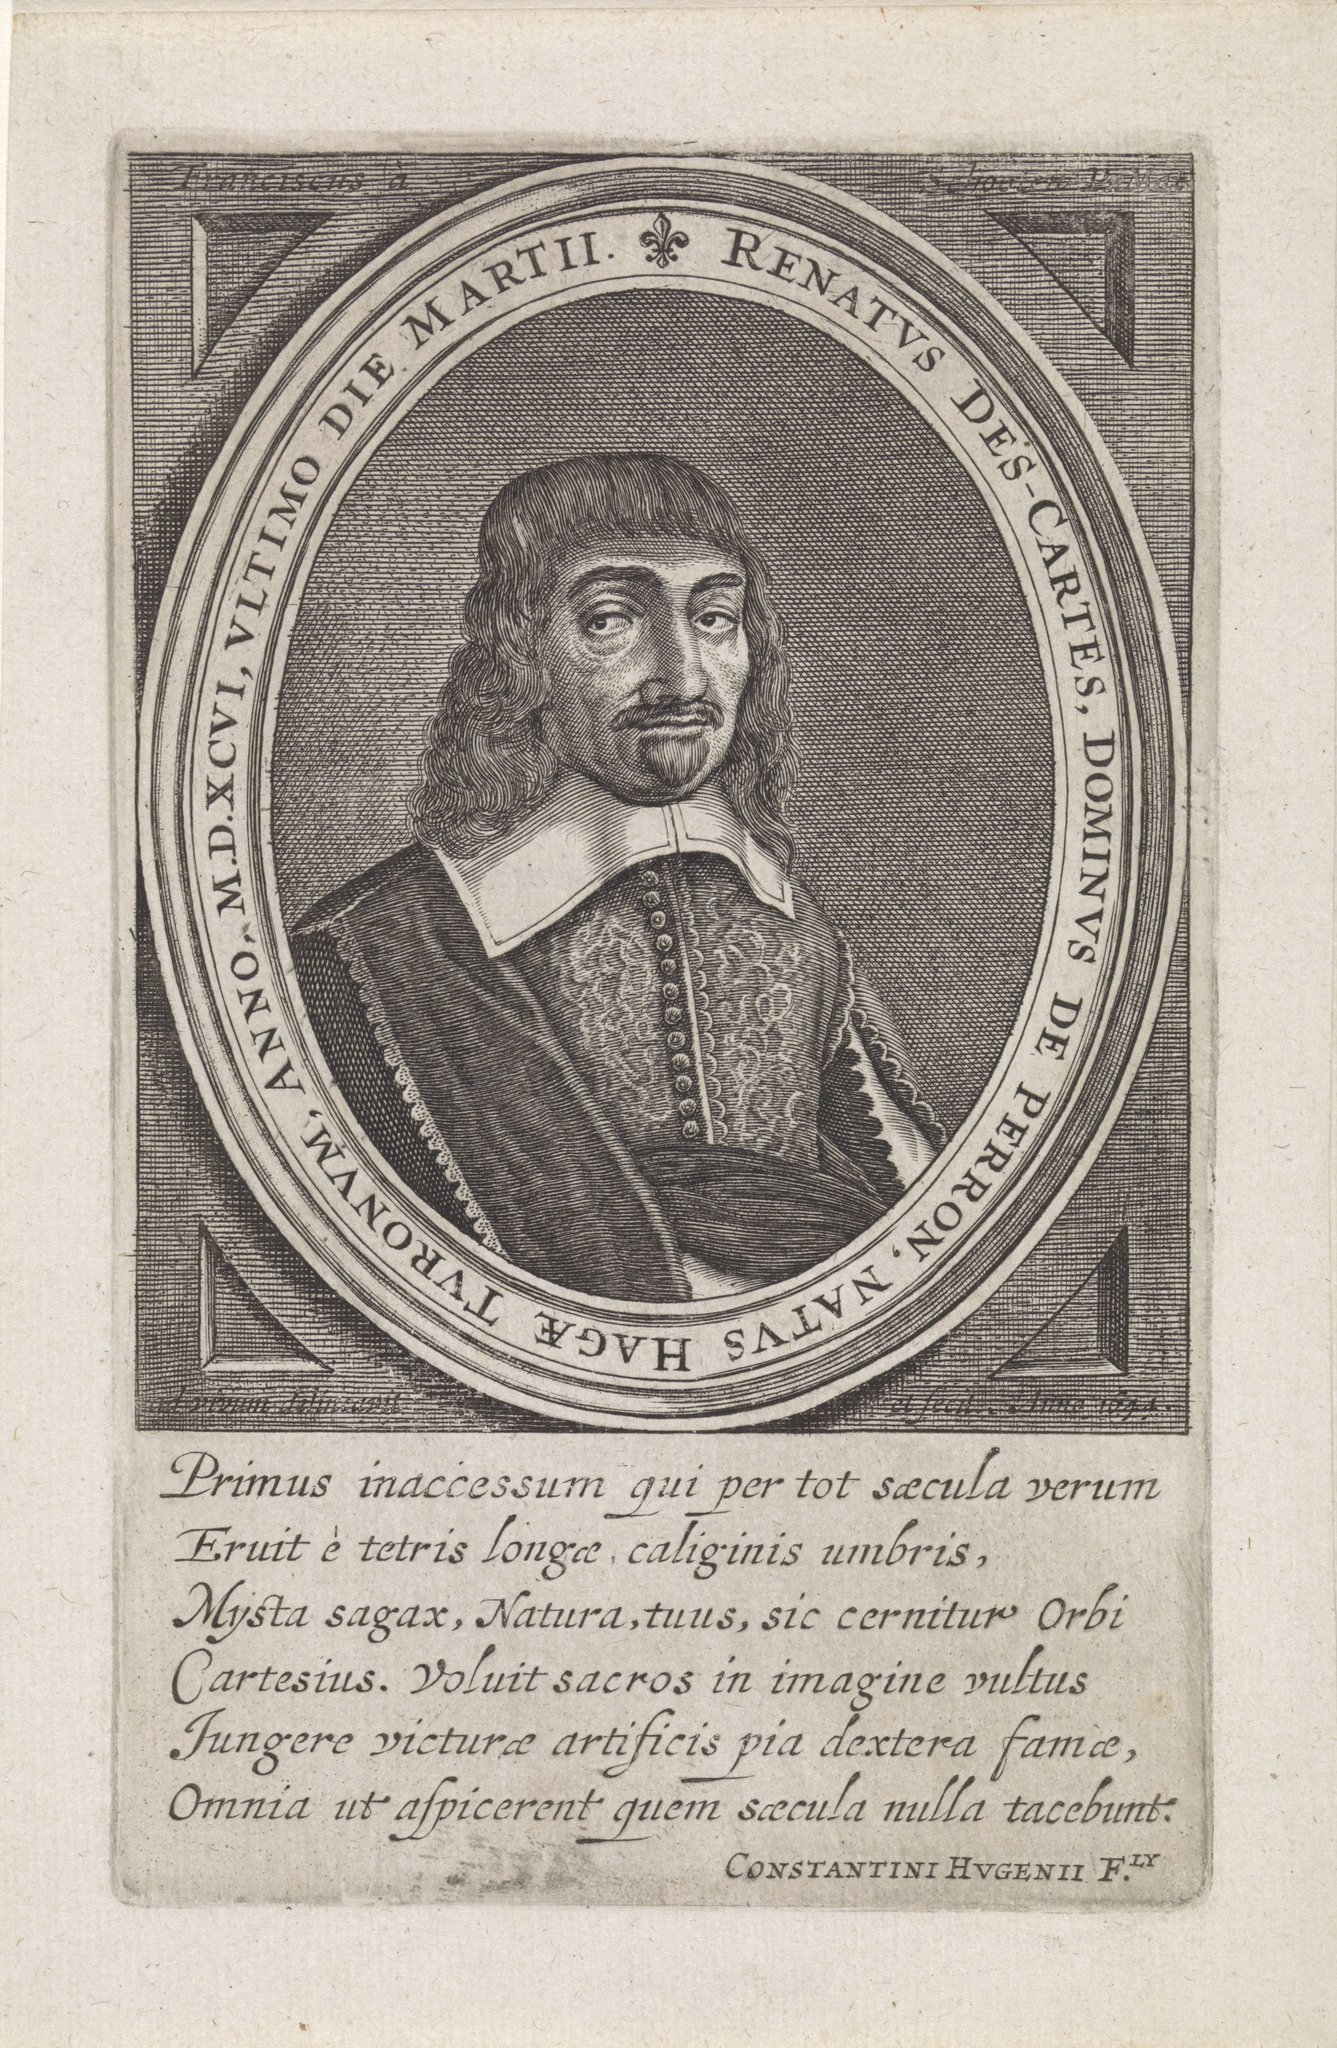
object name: book illustration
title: Portret van René Descartes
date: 1644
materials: paper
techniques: engraving, etching, letterpress printing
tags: rené descartes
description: Prent komt voor als boekillustratie in: René Descartes. Geometria. Met annotaties van Florimond de Beaune. Vertaald uit het Frans in het Latijn, vermeerderd en geannoteerd door Frans (II) van Schooten. Amsterdam: bij Lowijs (III) en Daniel Elzevier, 1659-1661.